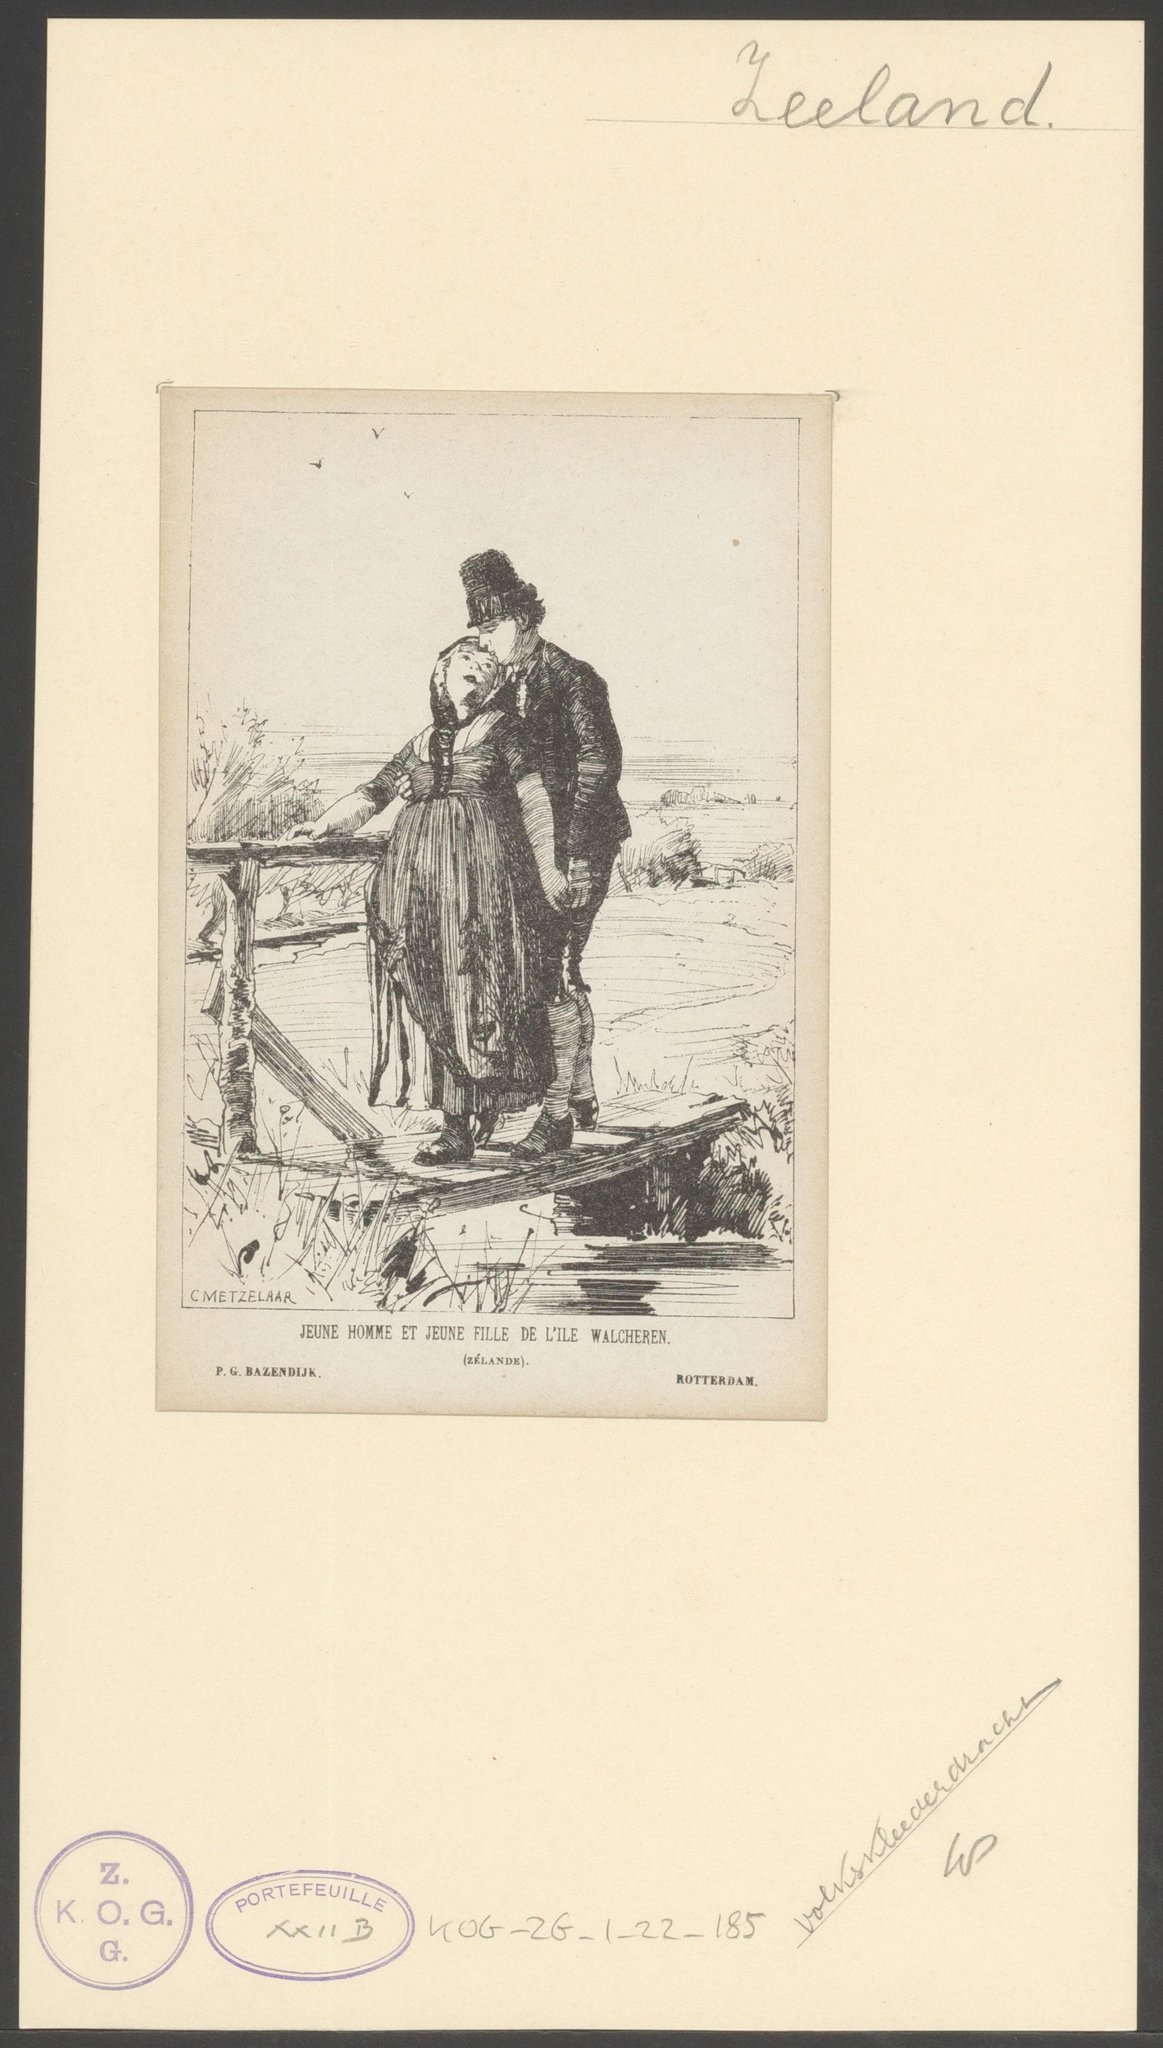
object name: print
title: Jonge man en vrouw van Walcheren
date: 1855-1881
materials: paper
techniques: lithograph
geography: rotterdam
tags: clothes, costume (+ women's clothes), clothes, costume (+ men's clothes), folk costume, regional costume, couple of lovers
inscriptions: collector's mark, collector's mark: Lugt 1641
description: Jonge man en jonge vrouw van Walcheren, liefdespaar staande op een houten bruggetje. Onderwerpsrubrieken binnen de Atlas Zeden en Gewoonten: De Kleeding, Volkskleederdracht, Zeeland.